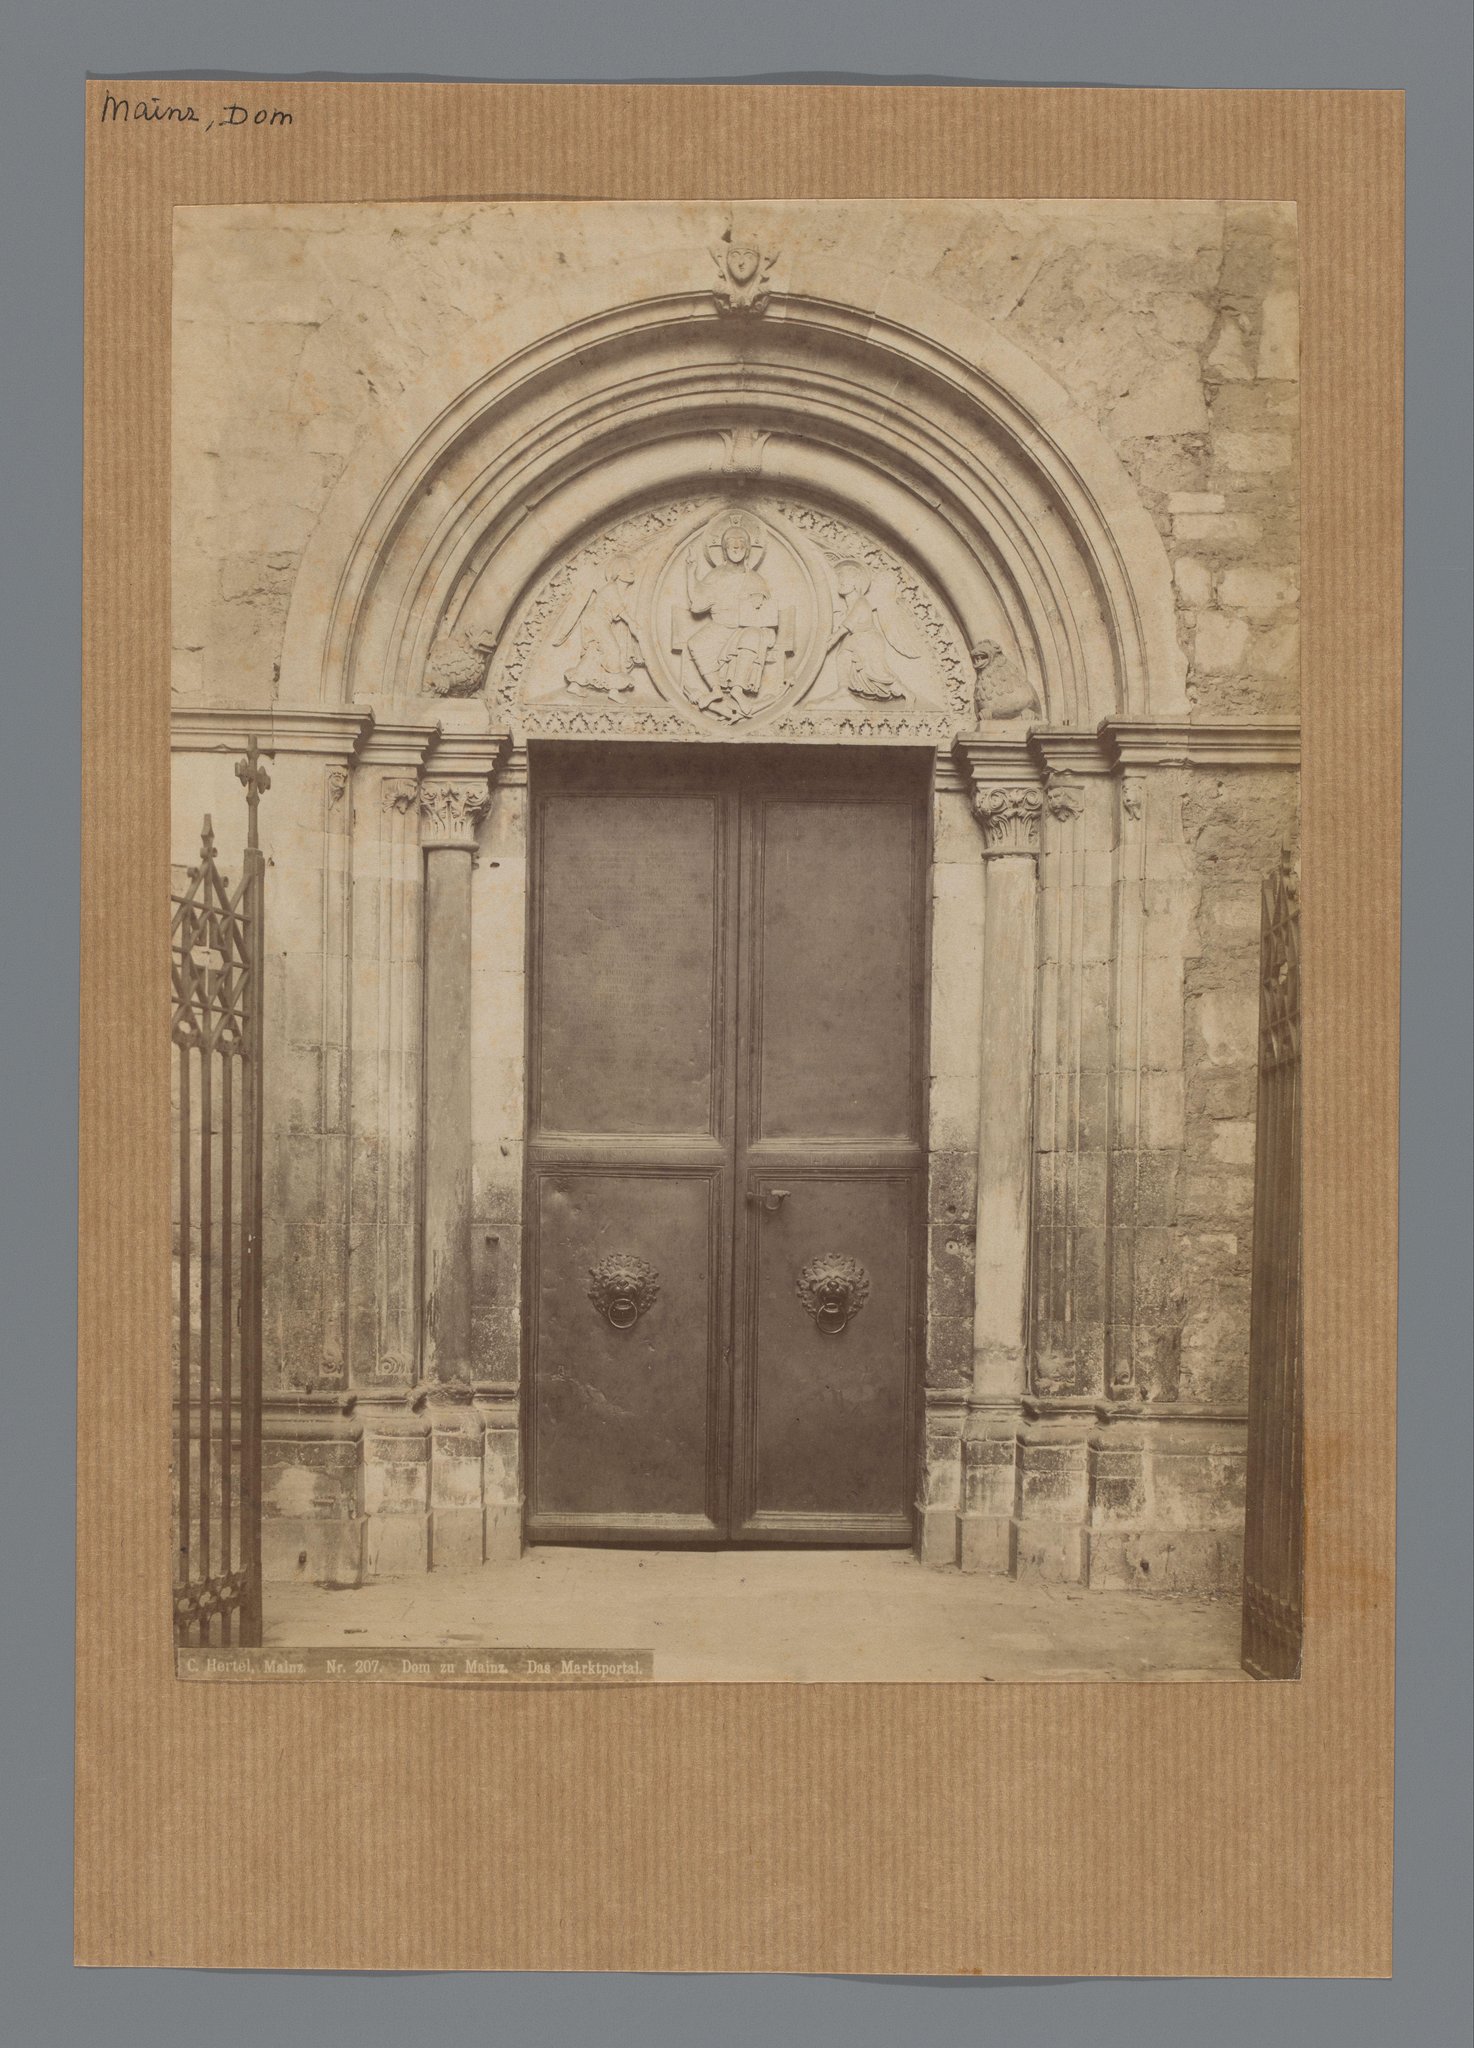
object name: photograph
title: Dom in Mainz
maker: carl hertel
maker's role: publisher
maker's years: 1832-1906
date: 1850-1900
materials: photographic support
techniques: albumen print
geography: mainz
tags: dom van mainz